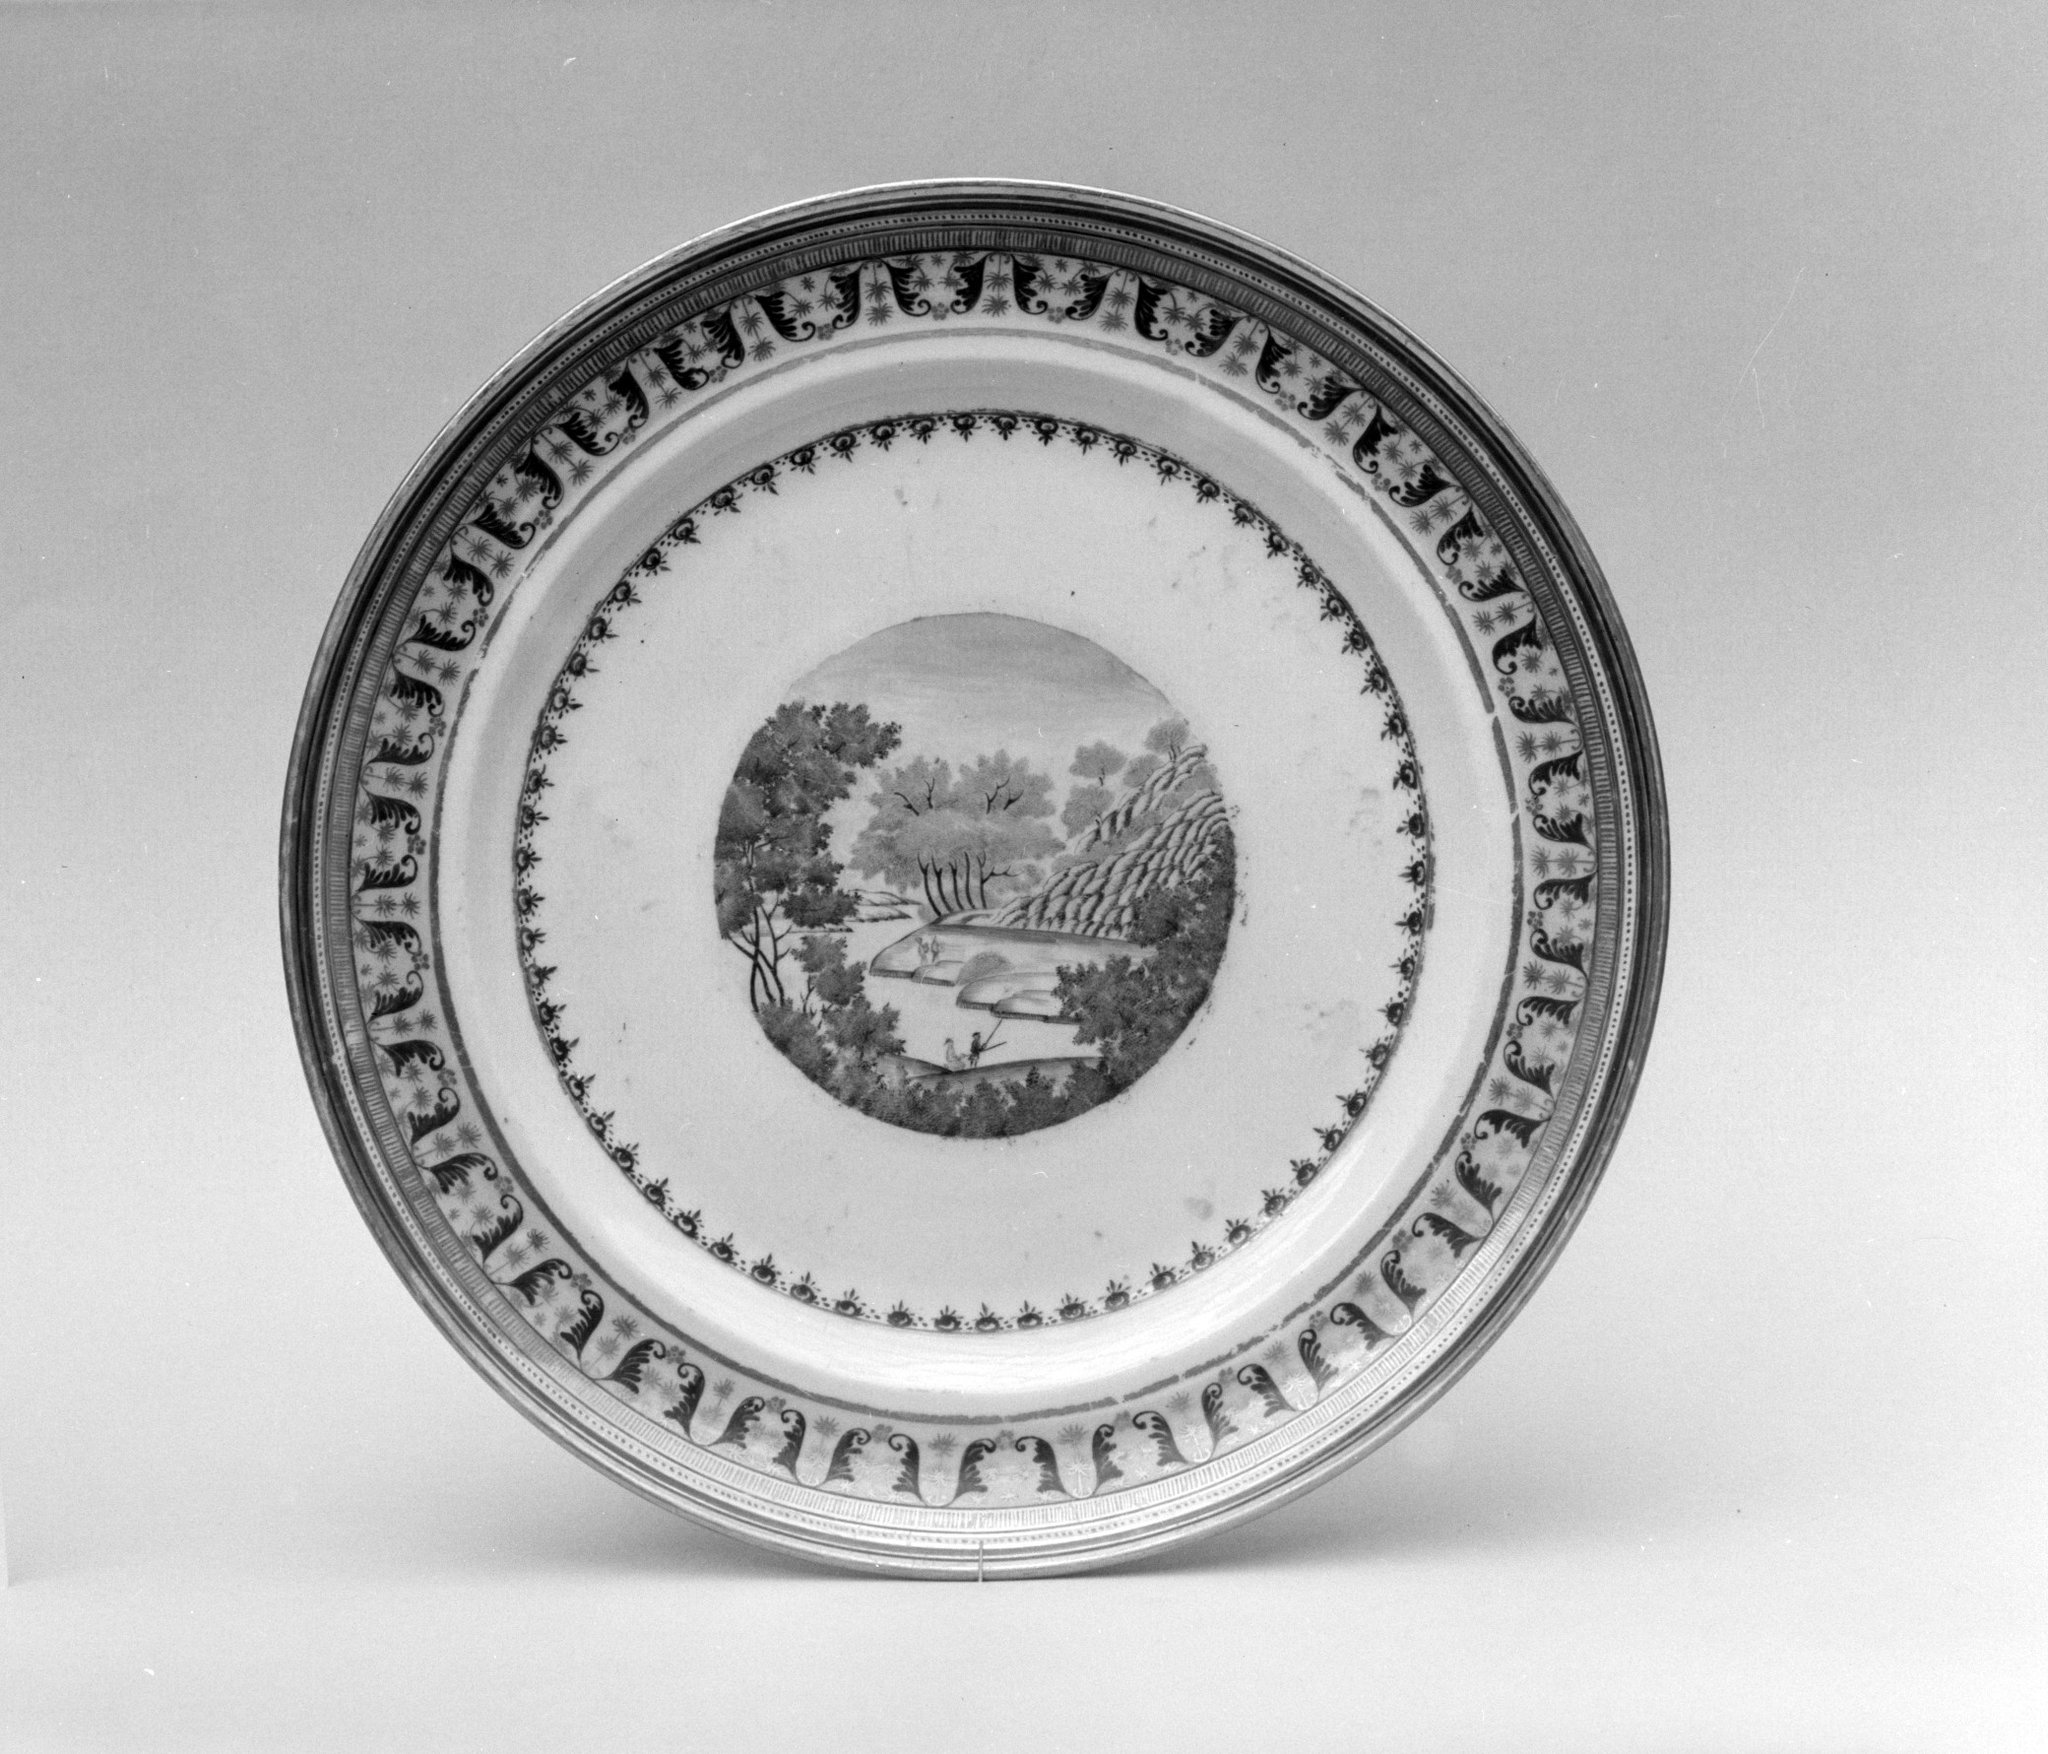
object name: plate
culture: chinese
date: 1800-1830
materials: porcelain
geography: china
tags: landscapes